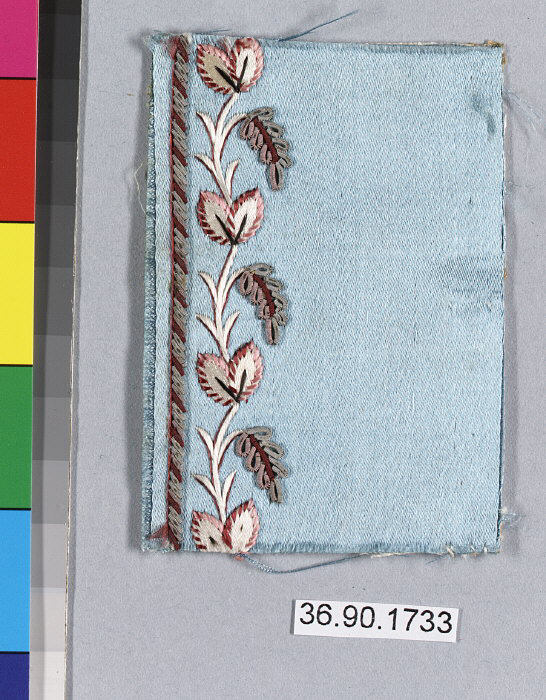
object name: sample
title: Embroidery sample for a man’s suit or waistcoat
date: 1785-1815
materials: metal thread, silk